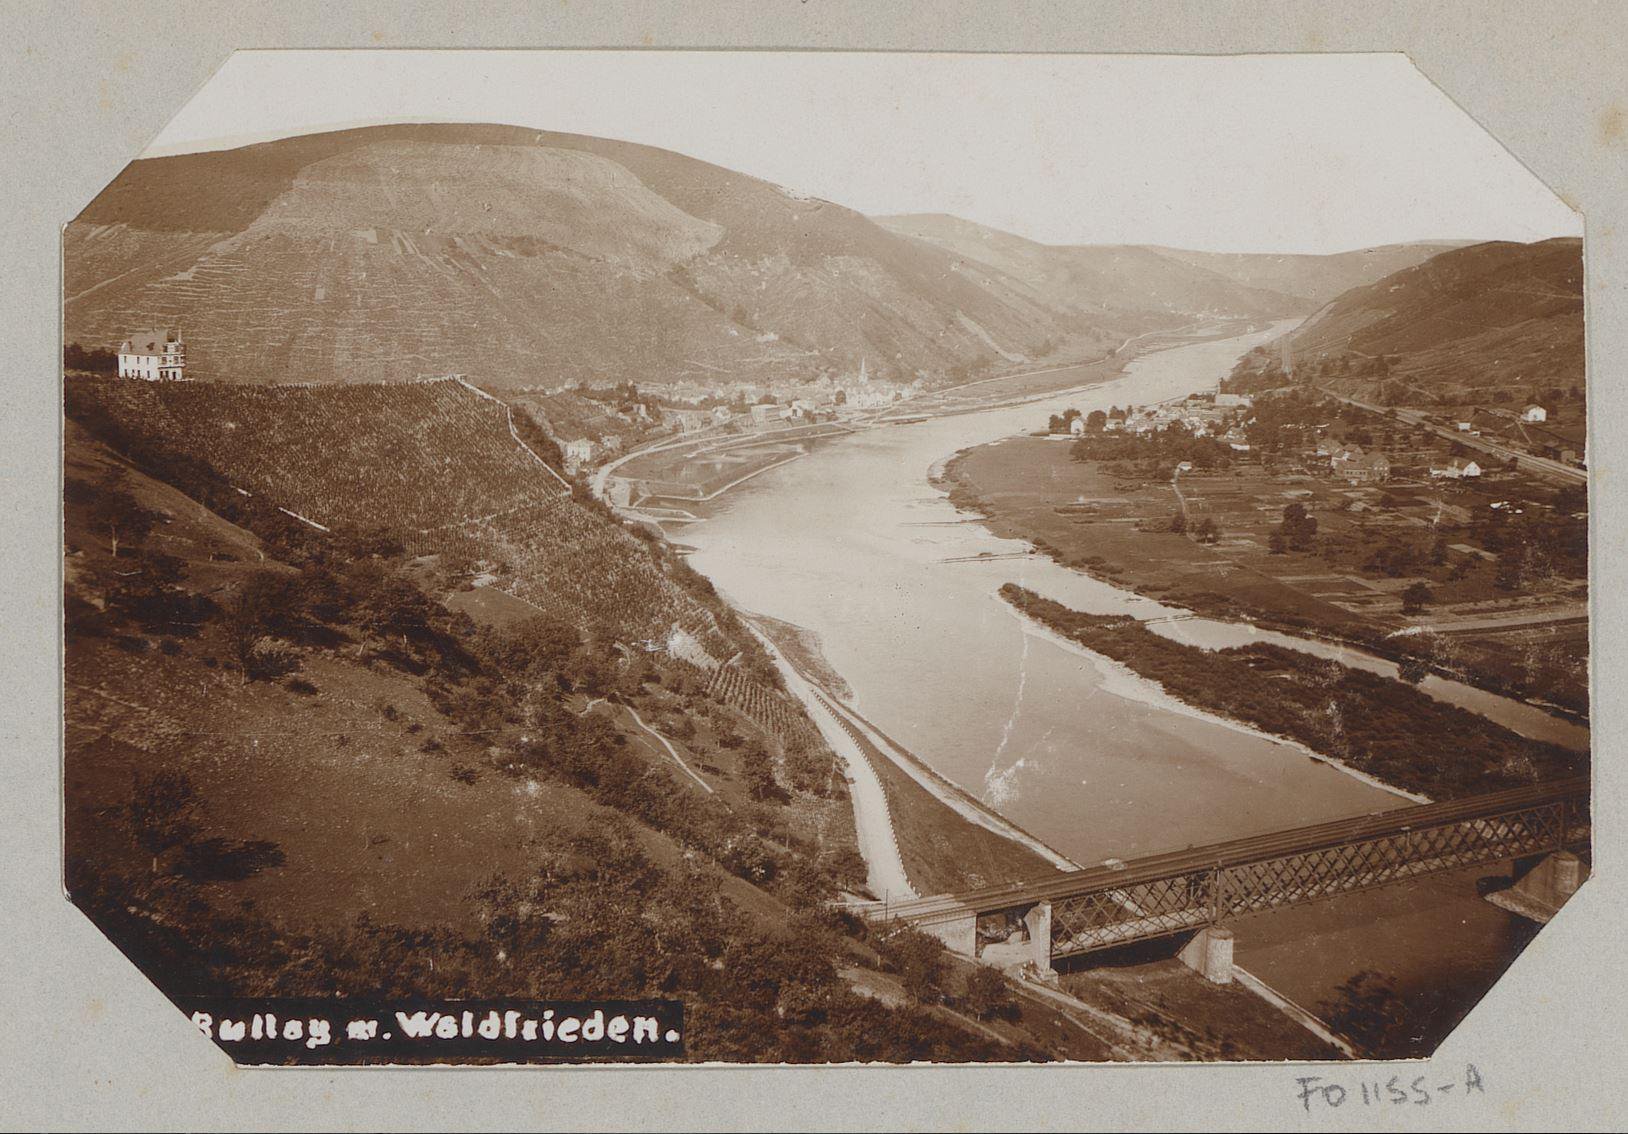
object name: album leaf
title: Gezicht op Alf en Bullay aan de Moezel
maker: Anonymous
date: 1890-1896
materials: photographic support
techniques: collodion silver print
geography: rhineland-palatinate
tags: city-view in general; 'veduta', river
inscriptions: annotation: ‘Reis Alf a/d Moesel/ augustus 1896’, annotation: ‘Bullay’